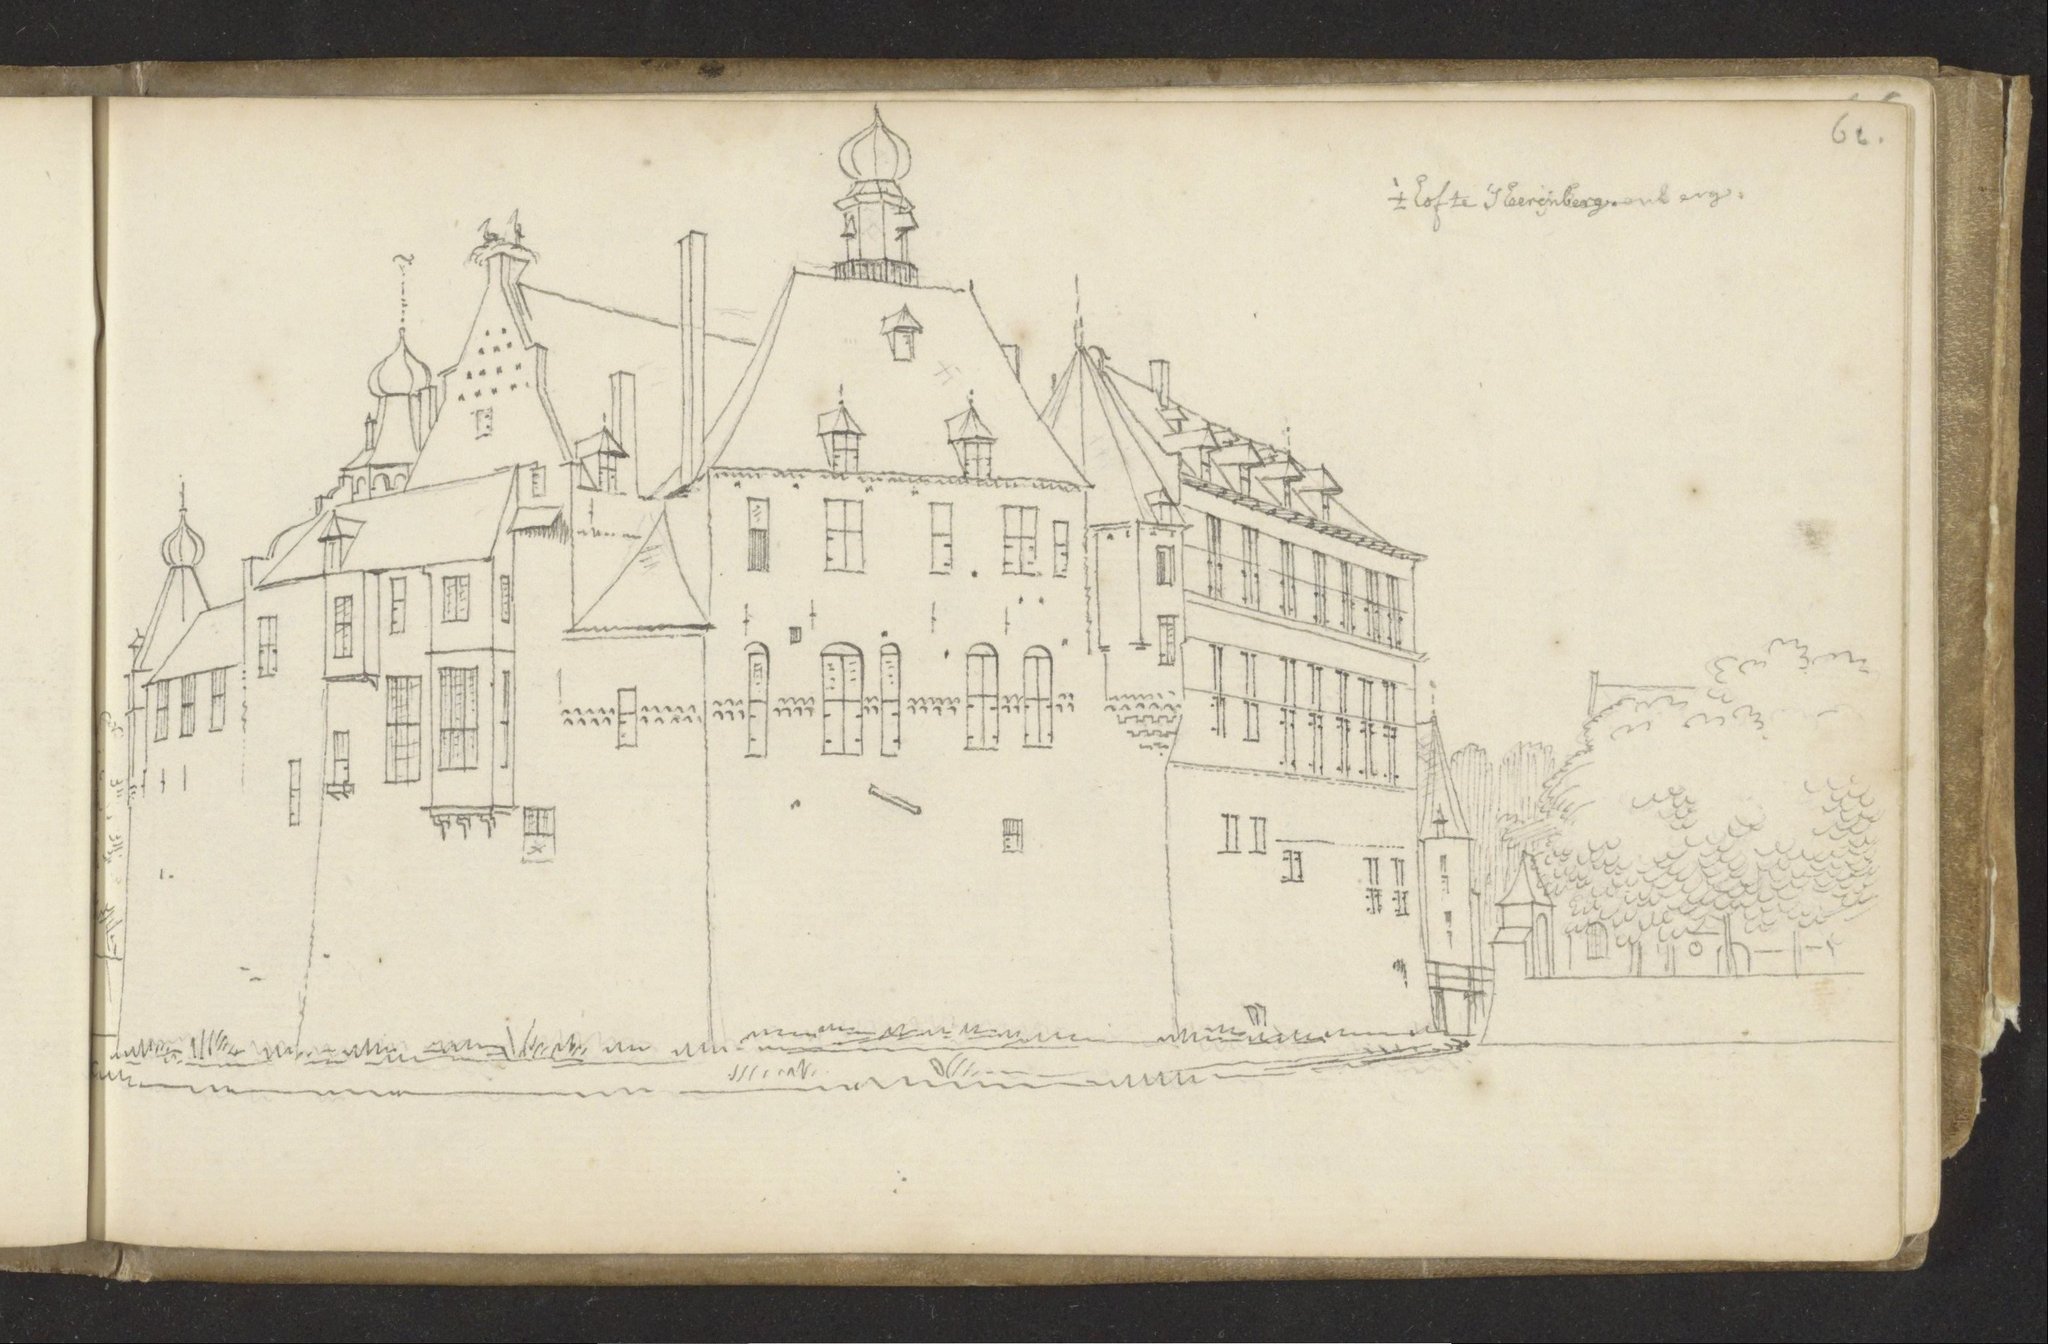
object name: sketchbook leaf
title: Huis Bergh te 's-Heerenberg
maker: abraham de haen (ii)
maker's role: draughtsman, print maker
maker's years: 1707-1748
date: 1731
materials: ink, pencil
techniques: pen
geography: s-heerenberg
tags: castle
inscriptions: annotation: ‘'t hof te 'sheerenberg’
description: Blad 62 recto uit een schetsboek met 69 bladen.